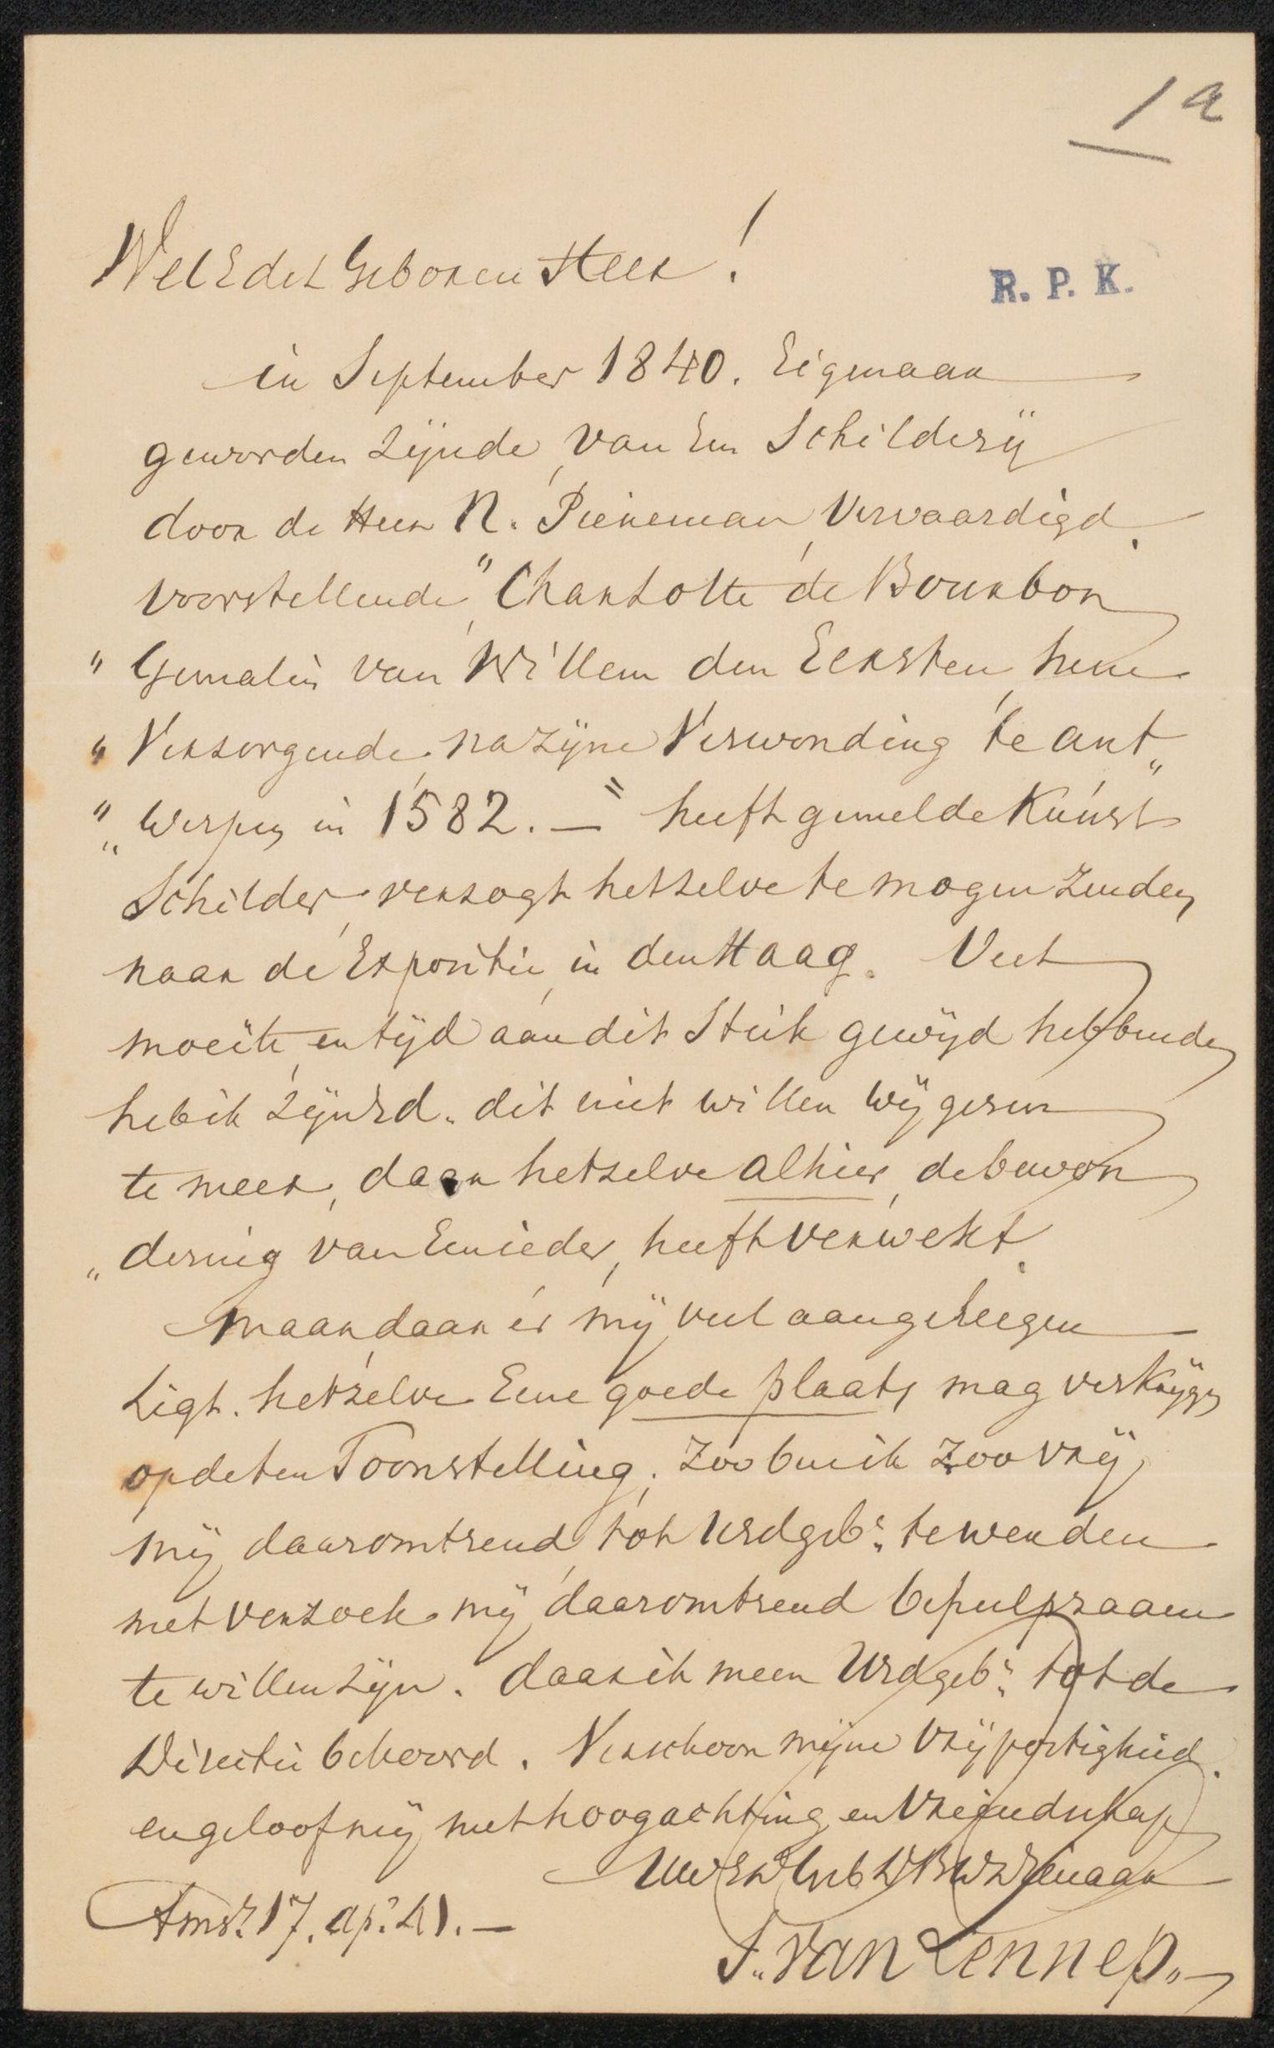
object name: letter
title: Brief aan Gerrit Lodewijk Hendric Hooft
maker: jacob van lennep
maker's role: tweede kamerlid, advocaat, dichter, historicus, lid tweede kamer, schrijver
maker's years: 1802-1868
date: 1841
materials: ink, paper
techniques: pen, writing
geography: amsterdam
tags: the hague, politician, mayor, painting (including book-illumination, miniature-painting), exhibition ~ art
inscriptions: collector's mark: Lugt 2233